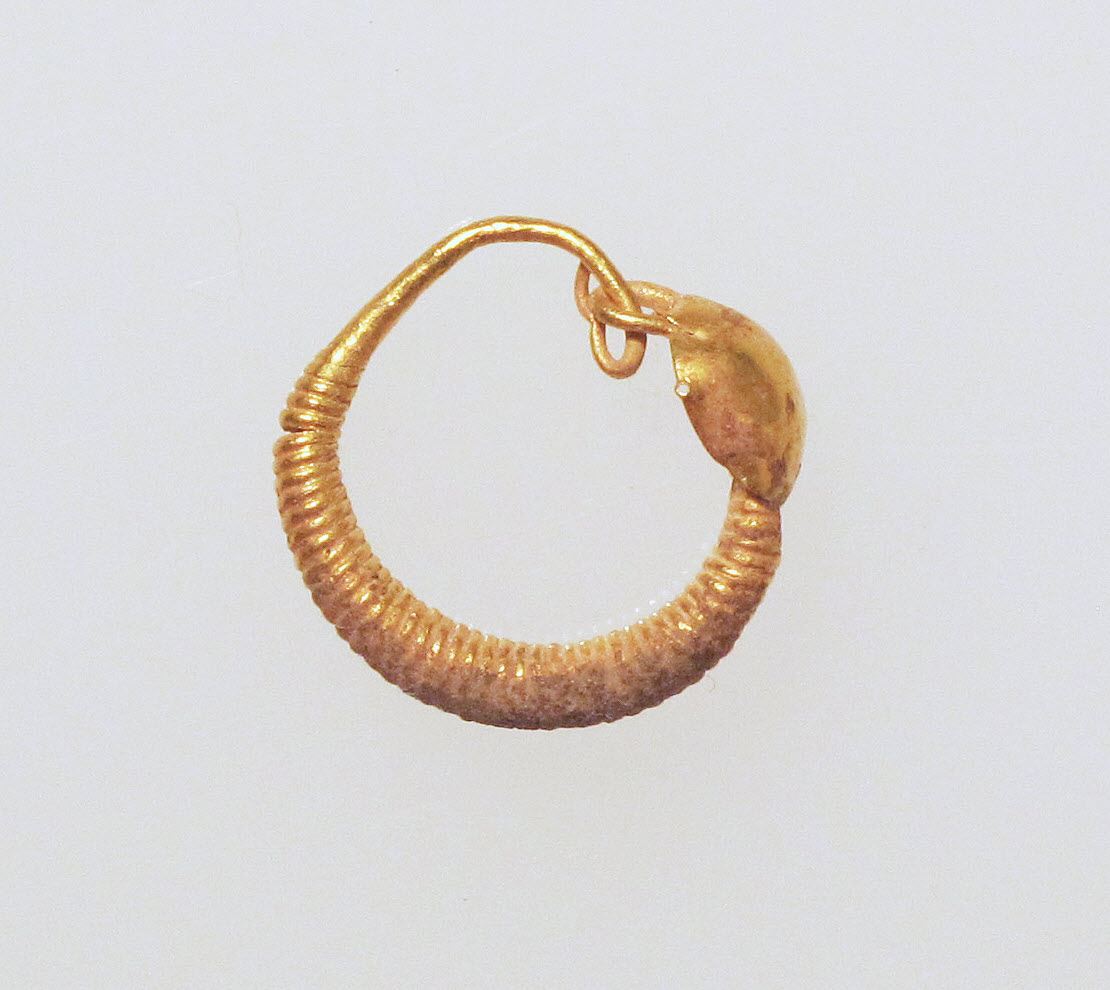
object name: earring with plain loop and disc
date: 7000 BCE-330 CE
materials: gold